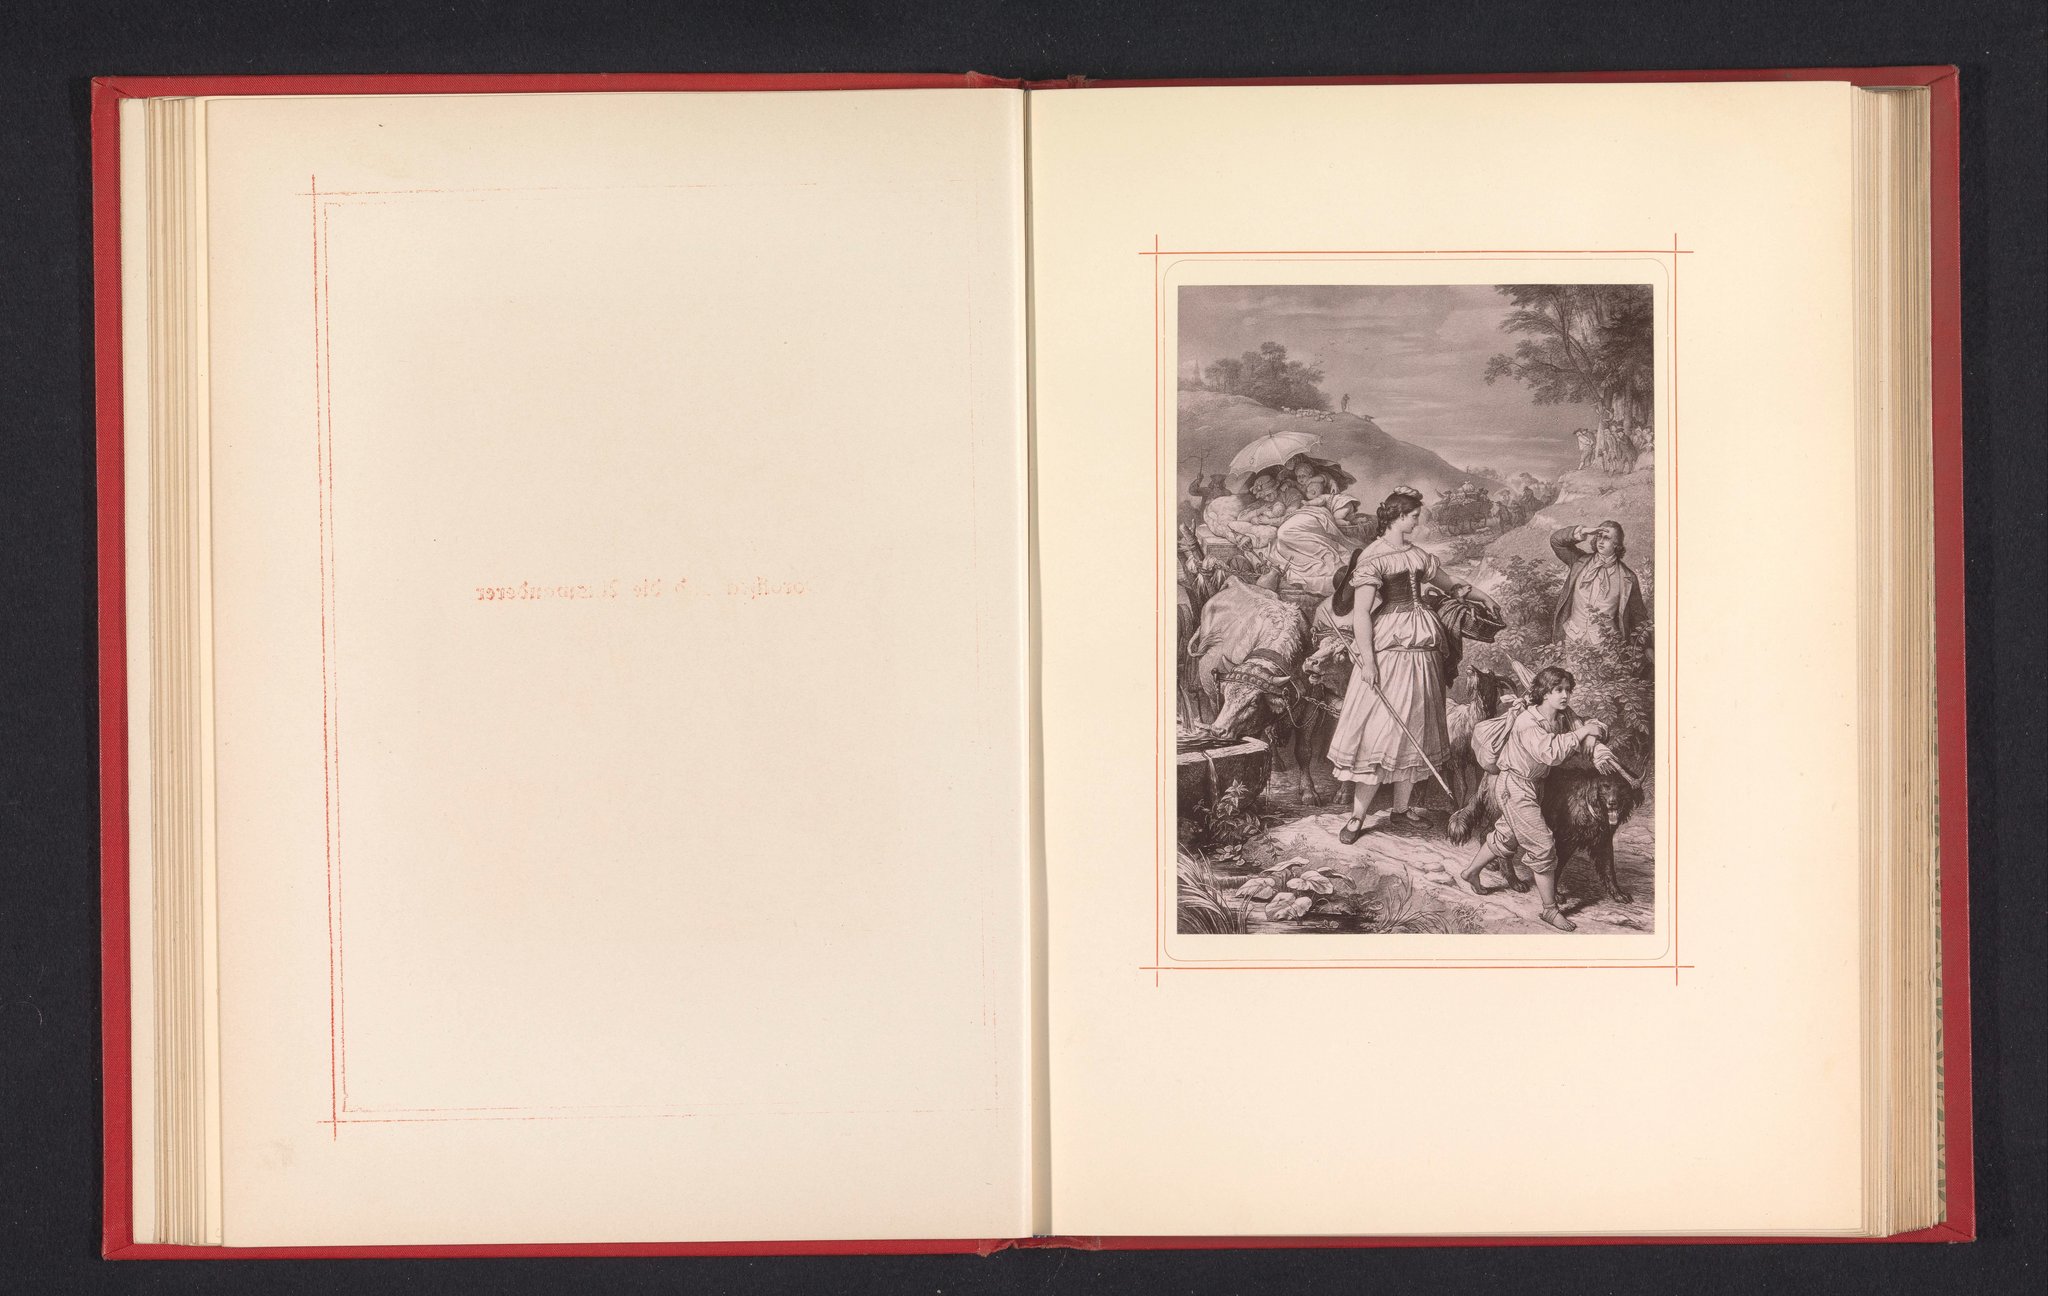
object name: photomechanical print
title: Fotoreproductie van een tekening, voorstellende Hermann ontmoet Dorothea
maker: Anonymous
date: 1875-1880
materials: paper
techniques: photograph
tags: animal traction, animal-drawn vehicle (carriage etc.), lovers' meeting